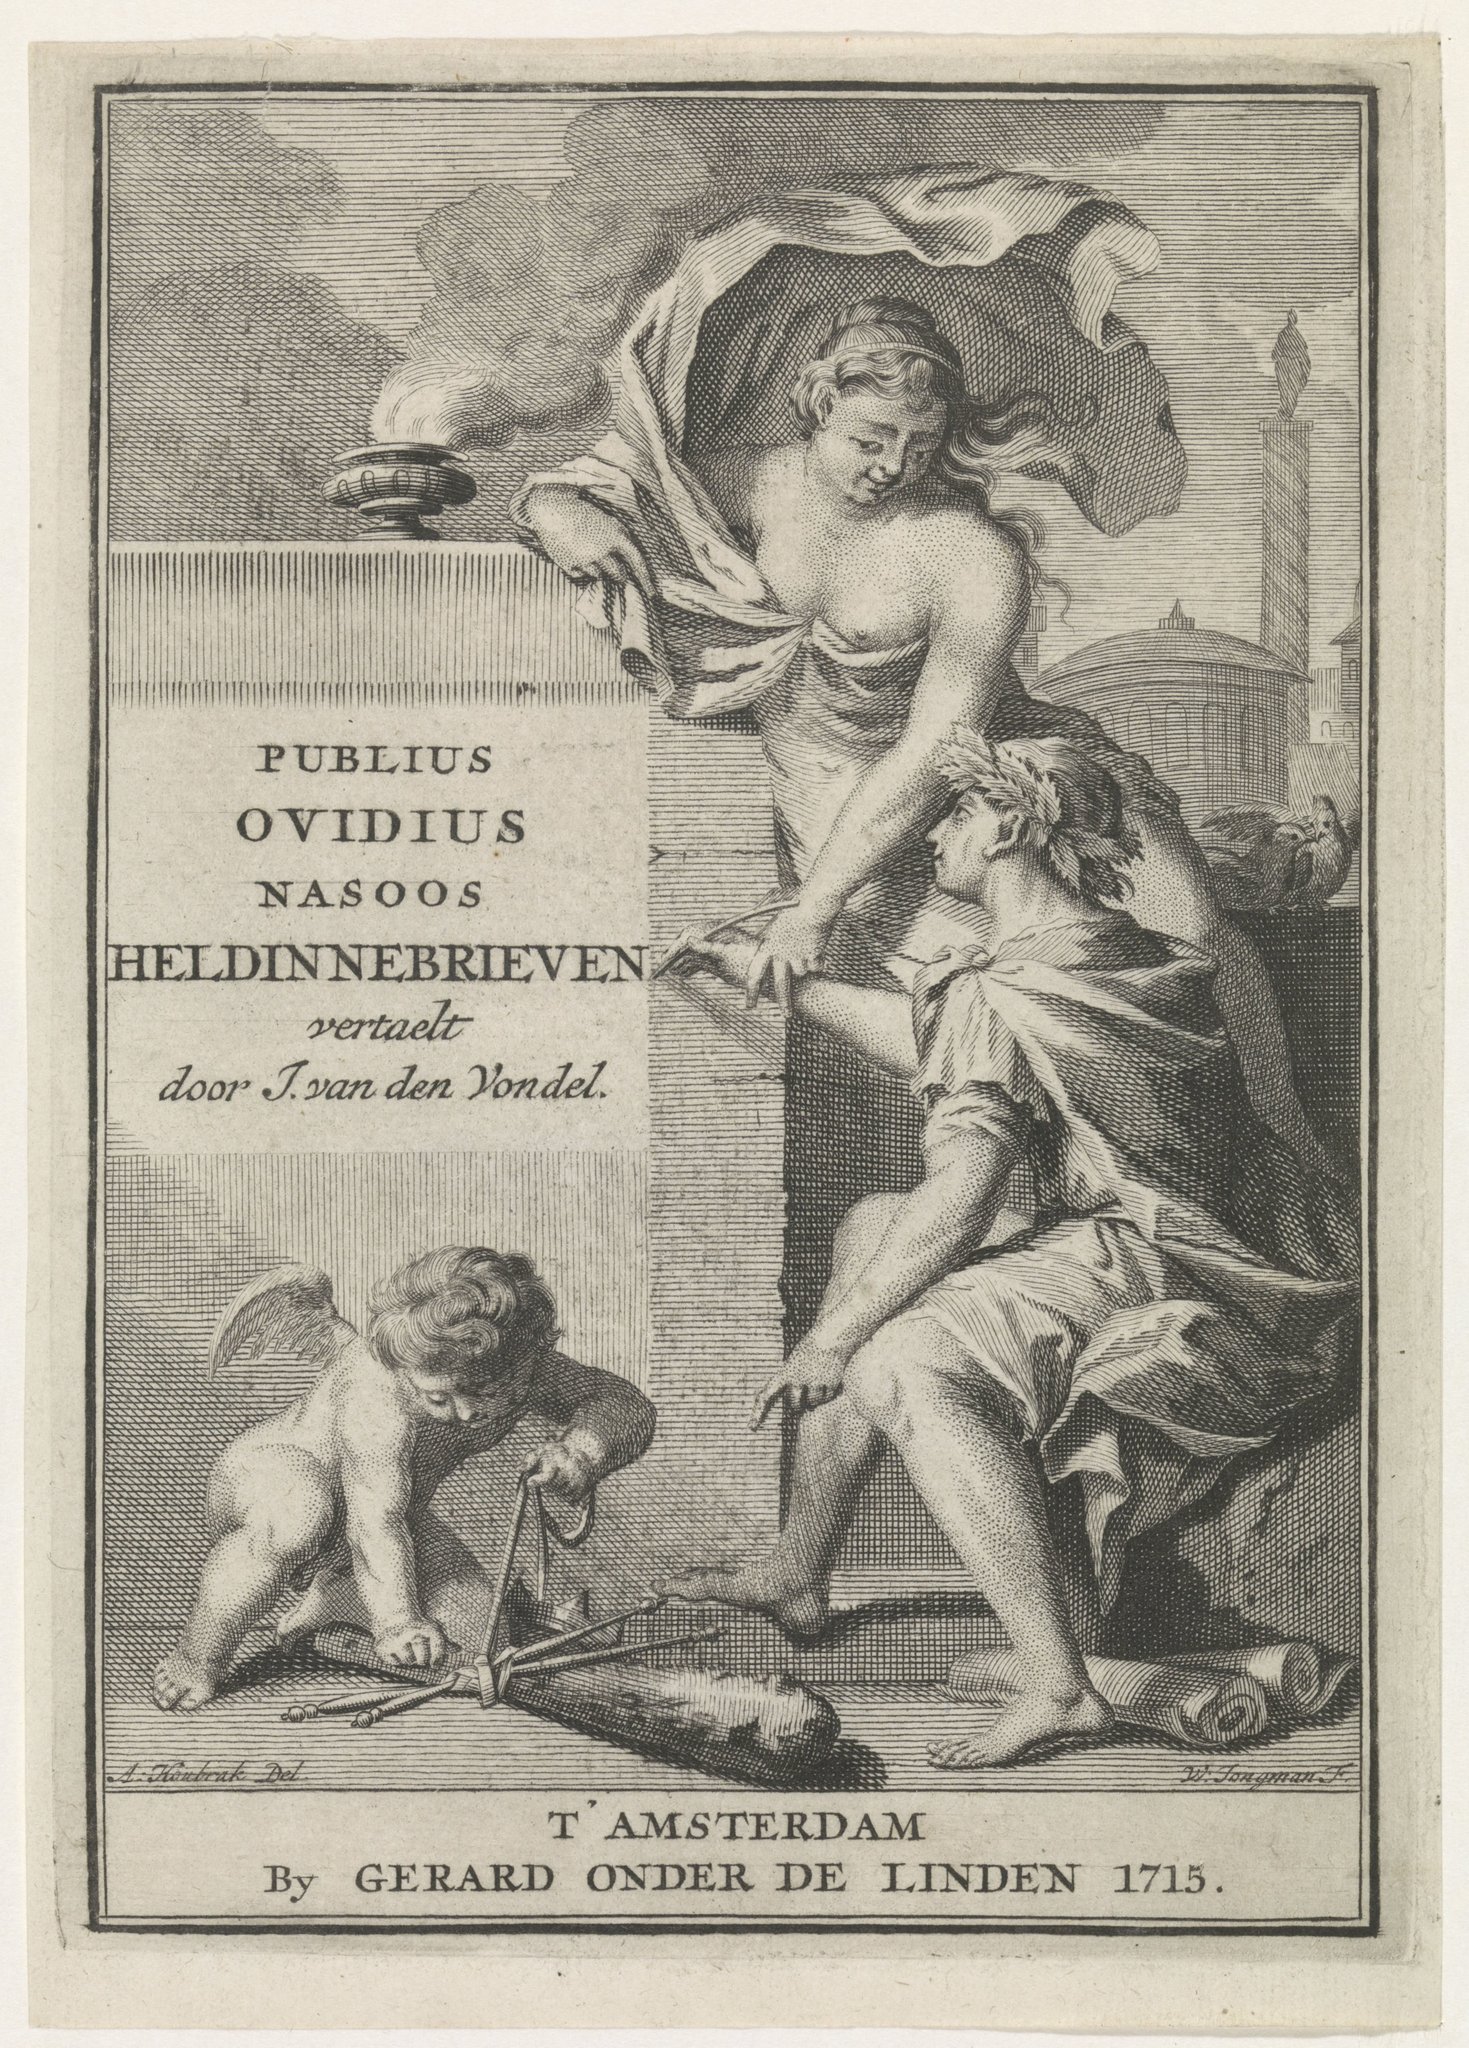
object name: titelblad, titelpagina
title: Vrouw in Grieks gewaad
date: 1715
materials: paper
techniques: engraving, etching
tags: other birds: turtle dove, cupids: 'amores', 'amoretti', 'putti', weapons for striking a blow: club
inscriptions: collector's mark: Lugt 2228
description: Een vrouw in Grieks gewaad, zittend op een muur. Naast haar twee duiven. Met haar linkerhand leidt ze de rechterhand van een man, gekroond met laurierkrans, die de titel met een veer op een kader schrijft. Op de voorgrond een putto met diverse attributen waaronder een knots.